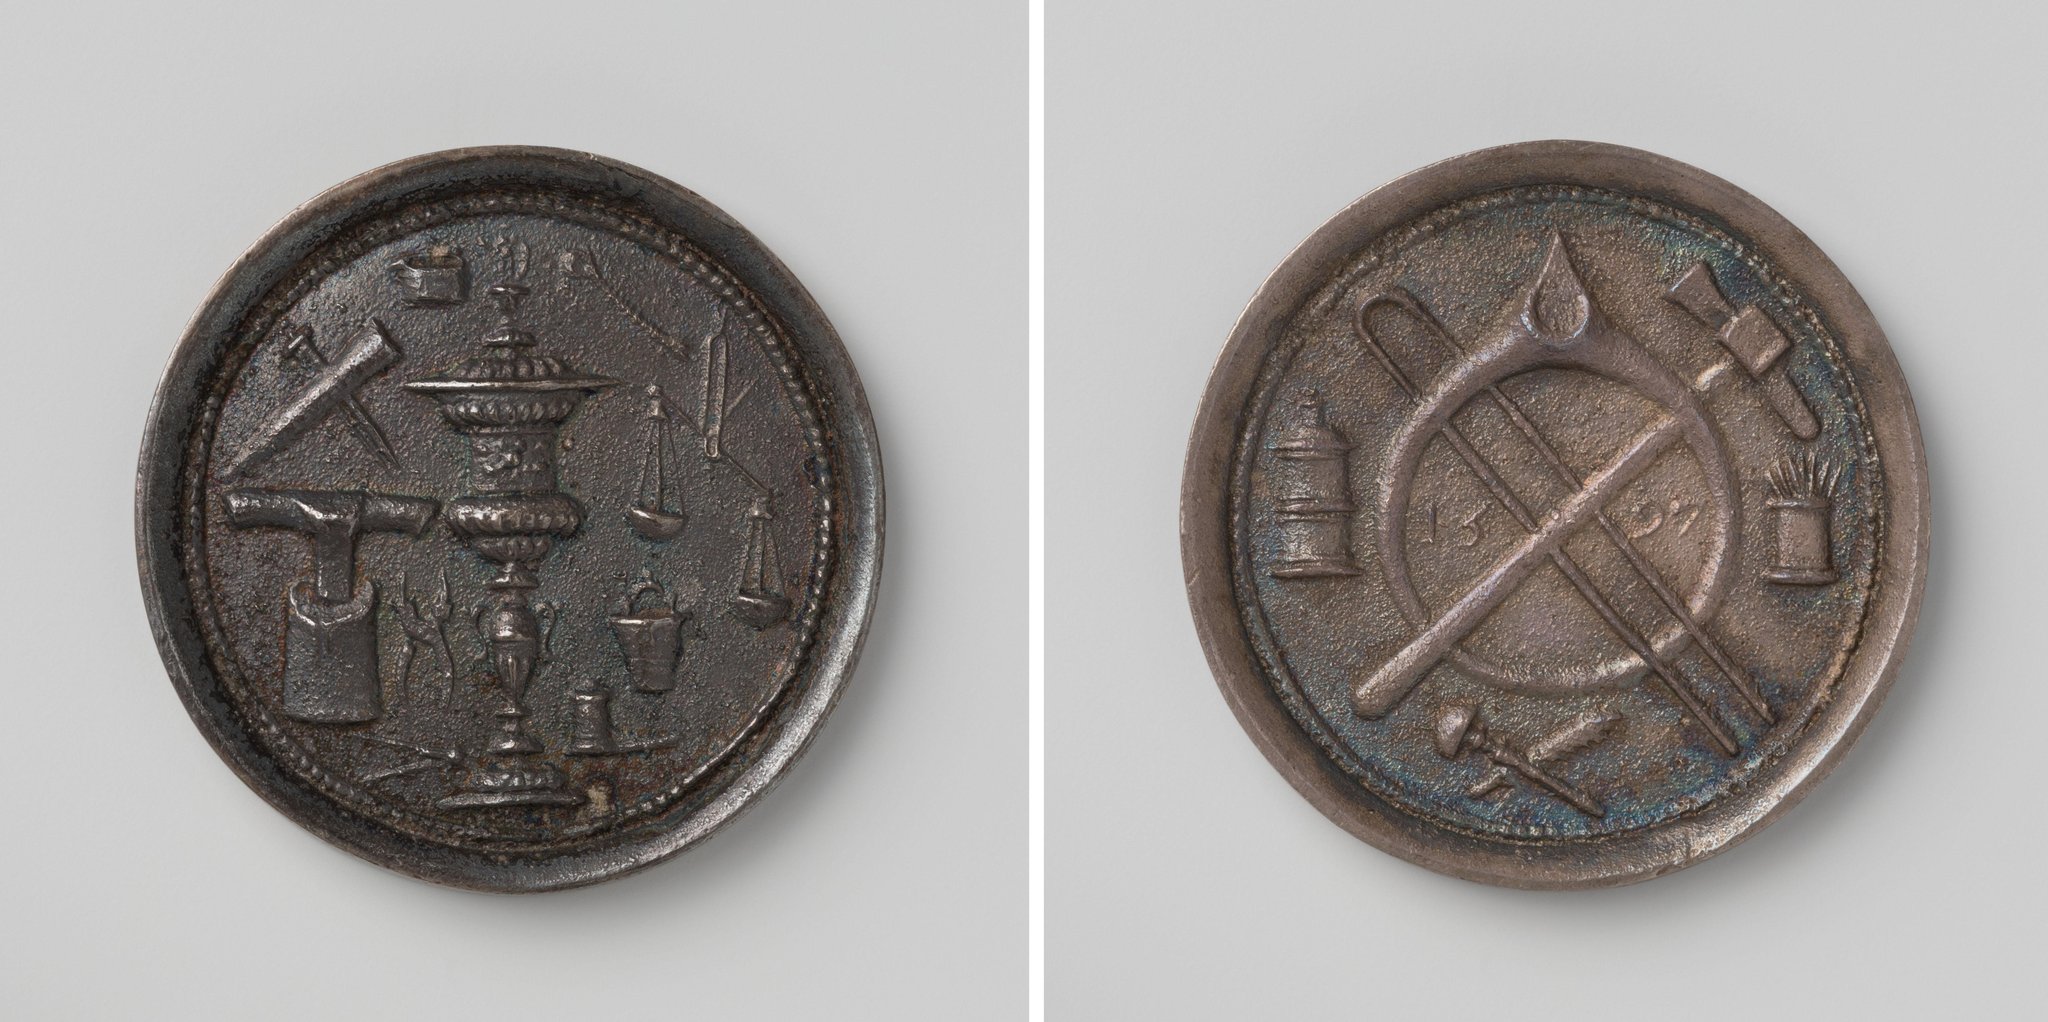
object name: medal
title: Zilversmedengilde van Antwerpen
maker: Anonymous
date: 1597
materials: silver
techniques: casting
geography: antwerp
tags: antwerp